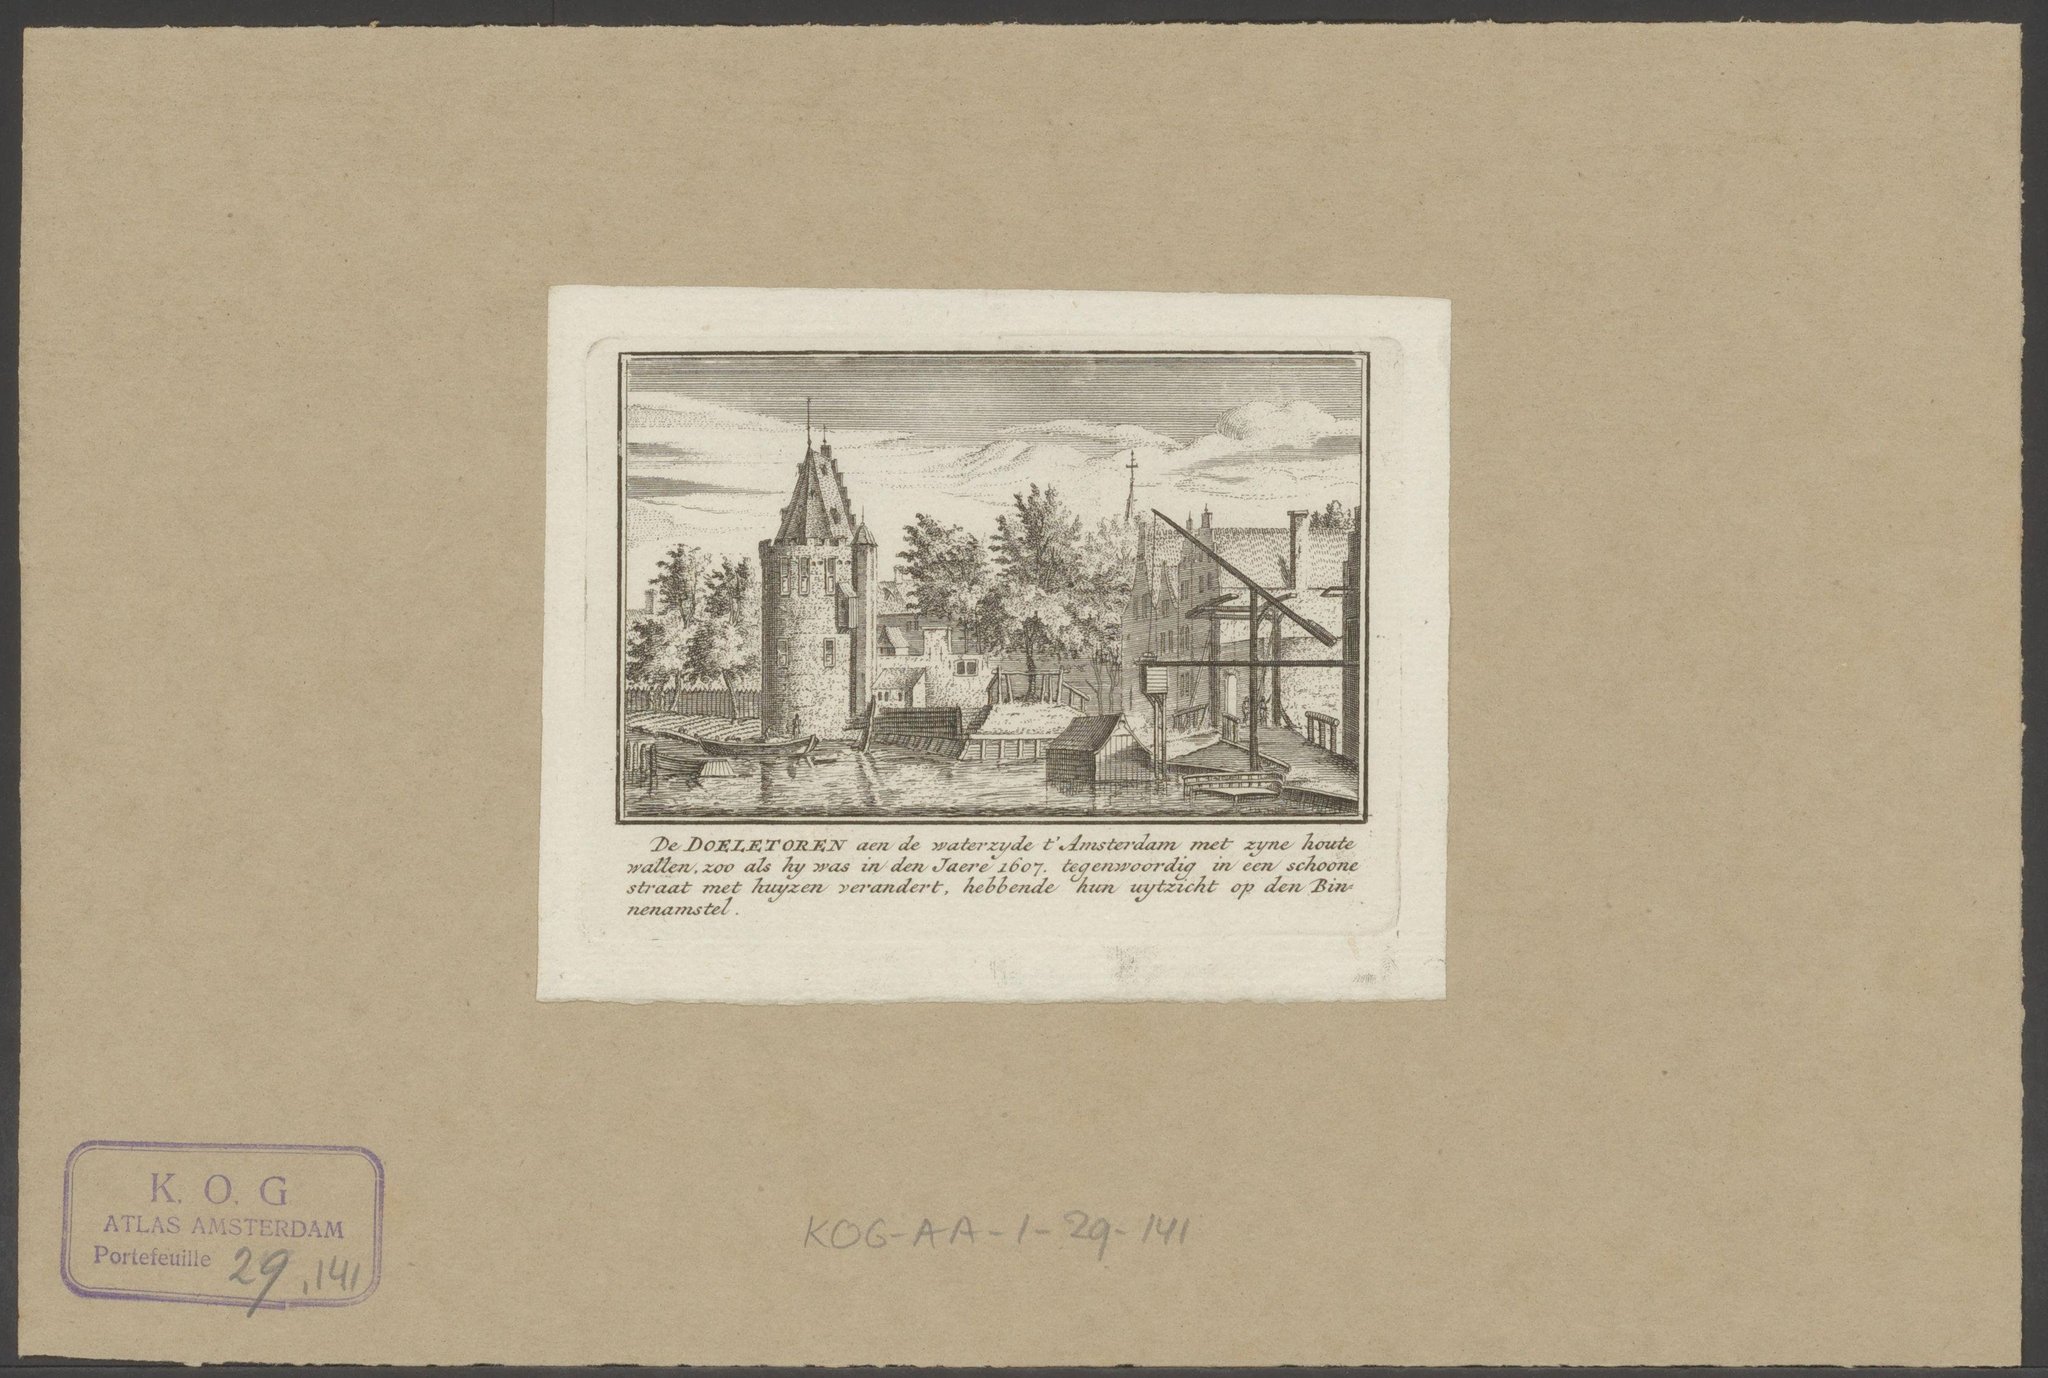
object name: print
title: Gezicht op de toren Swych Utrecht te Amsterdam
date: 1726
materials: paper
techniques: engraving, etching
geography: northern netherlands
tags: bridge in city across river, canal, etc. (+ city(-scape) with figures, staffage), towers ~ fortified city, rowing-boat, canoe, etc.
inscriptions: collector's mark: Lugt 1641b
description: Prent mogelijk uit: Rademaker, Abraham. Versameling van 100. Nederlantse Outheden en Gesigten. Amsterdam: Isaac Greve, [ca. 1726].